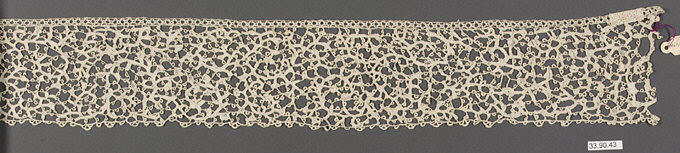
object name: edging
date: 1601-1700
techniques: lace